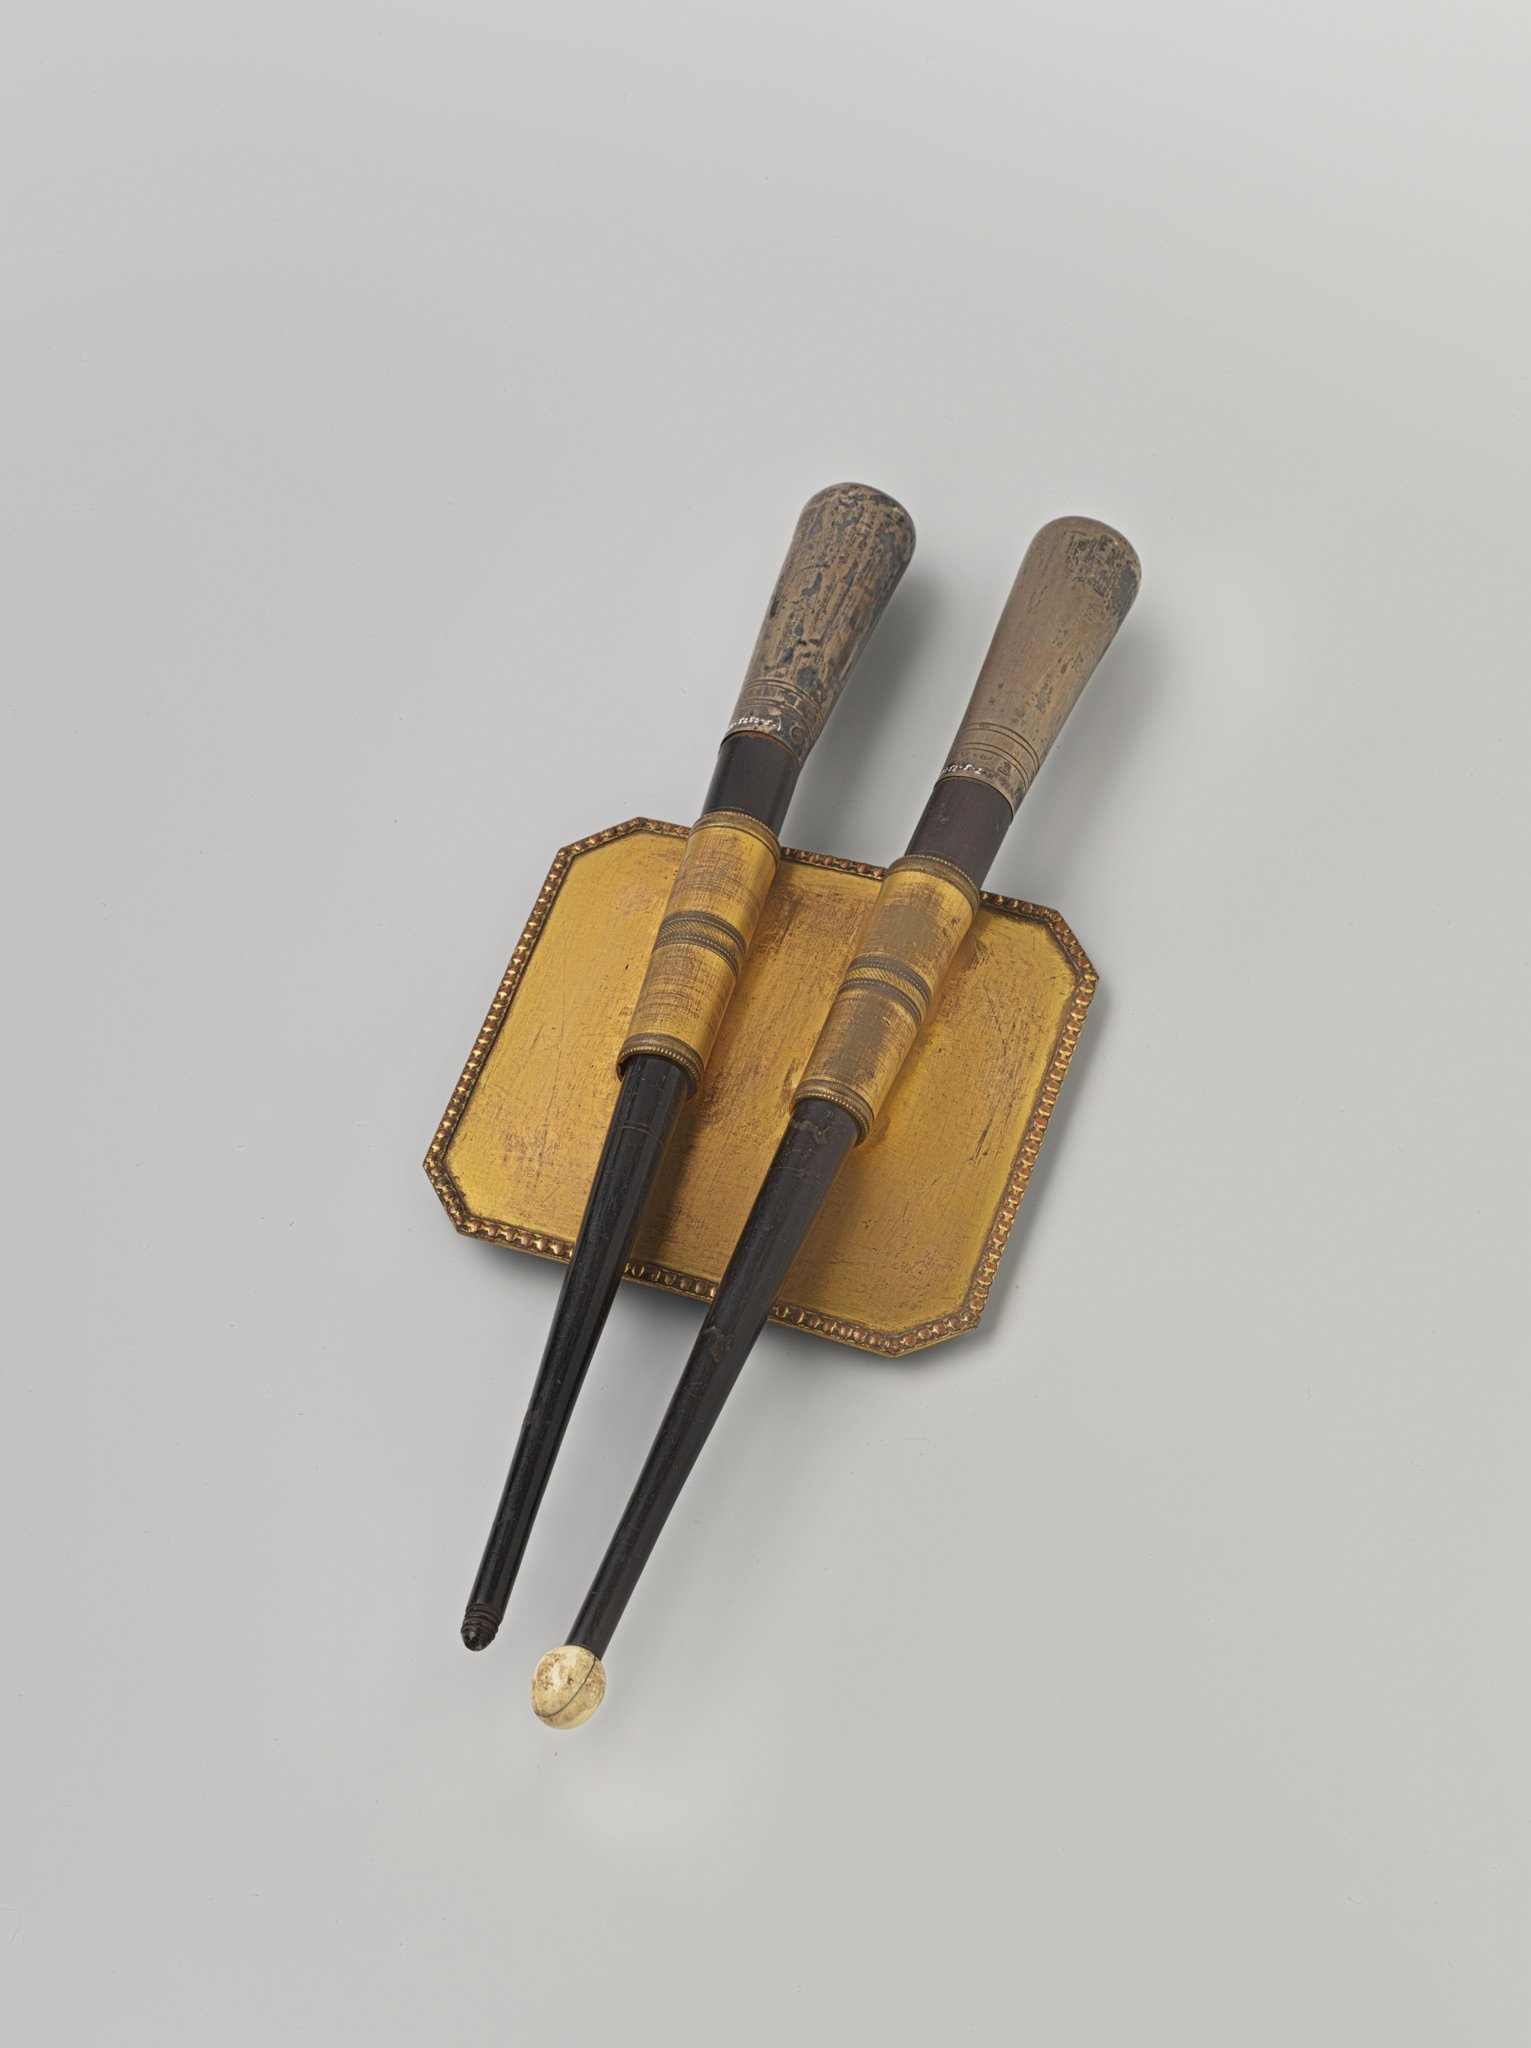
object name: stick plate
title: Drumsticks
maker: Anonymous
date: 1817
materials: wood, ivory, silver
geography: netherlands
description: Een ebbenhouten tromstok met ivoren knop. Stokken bezet met zilveren bussen.